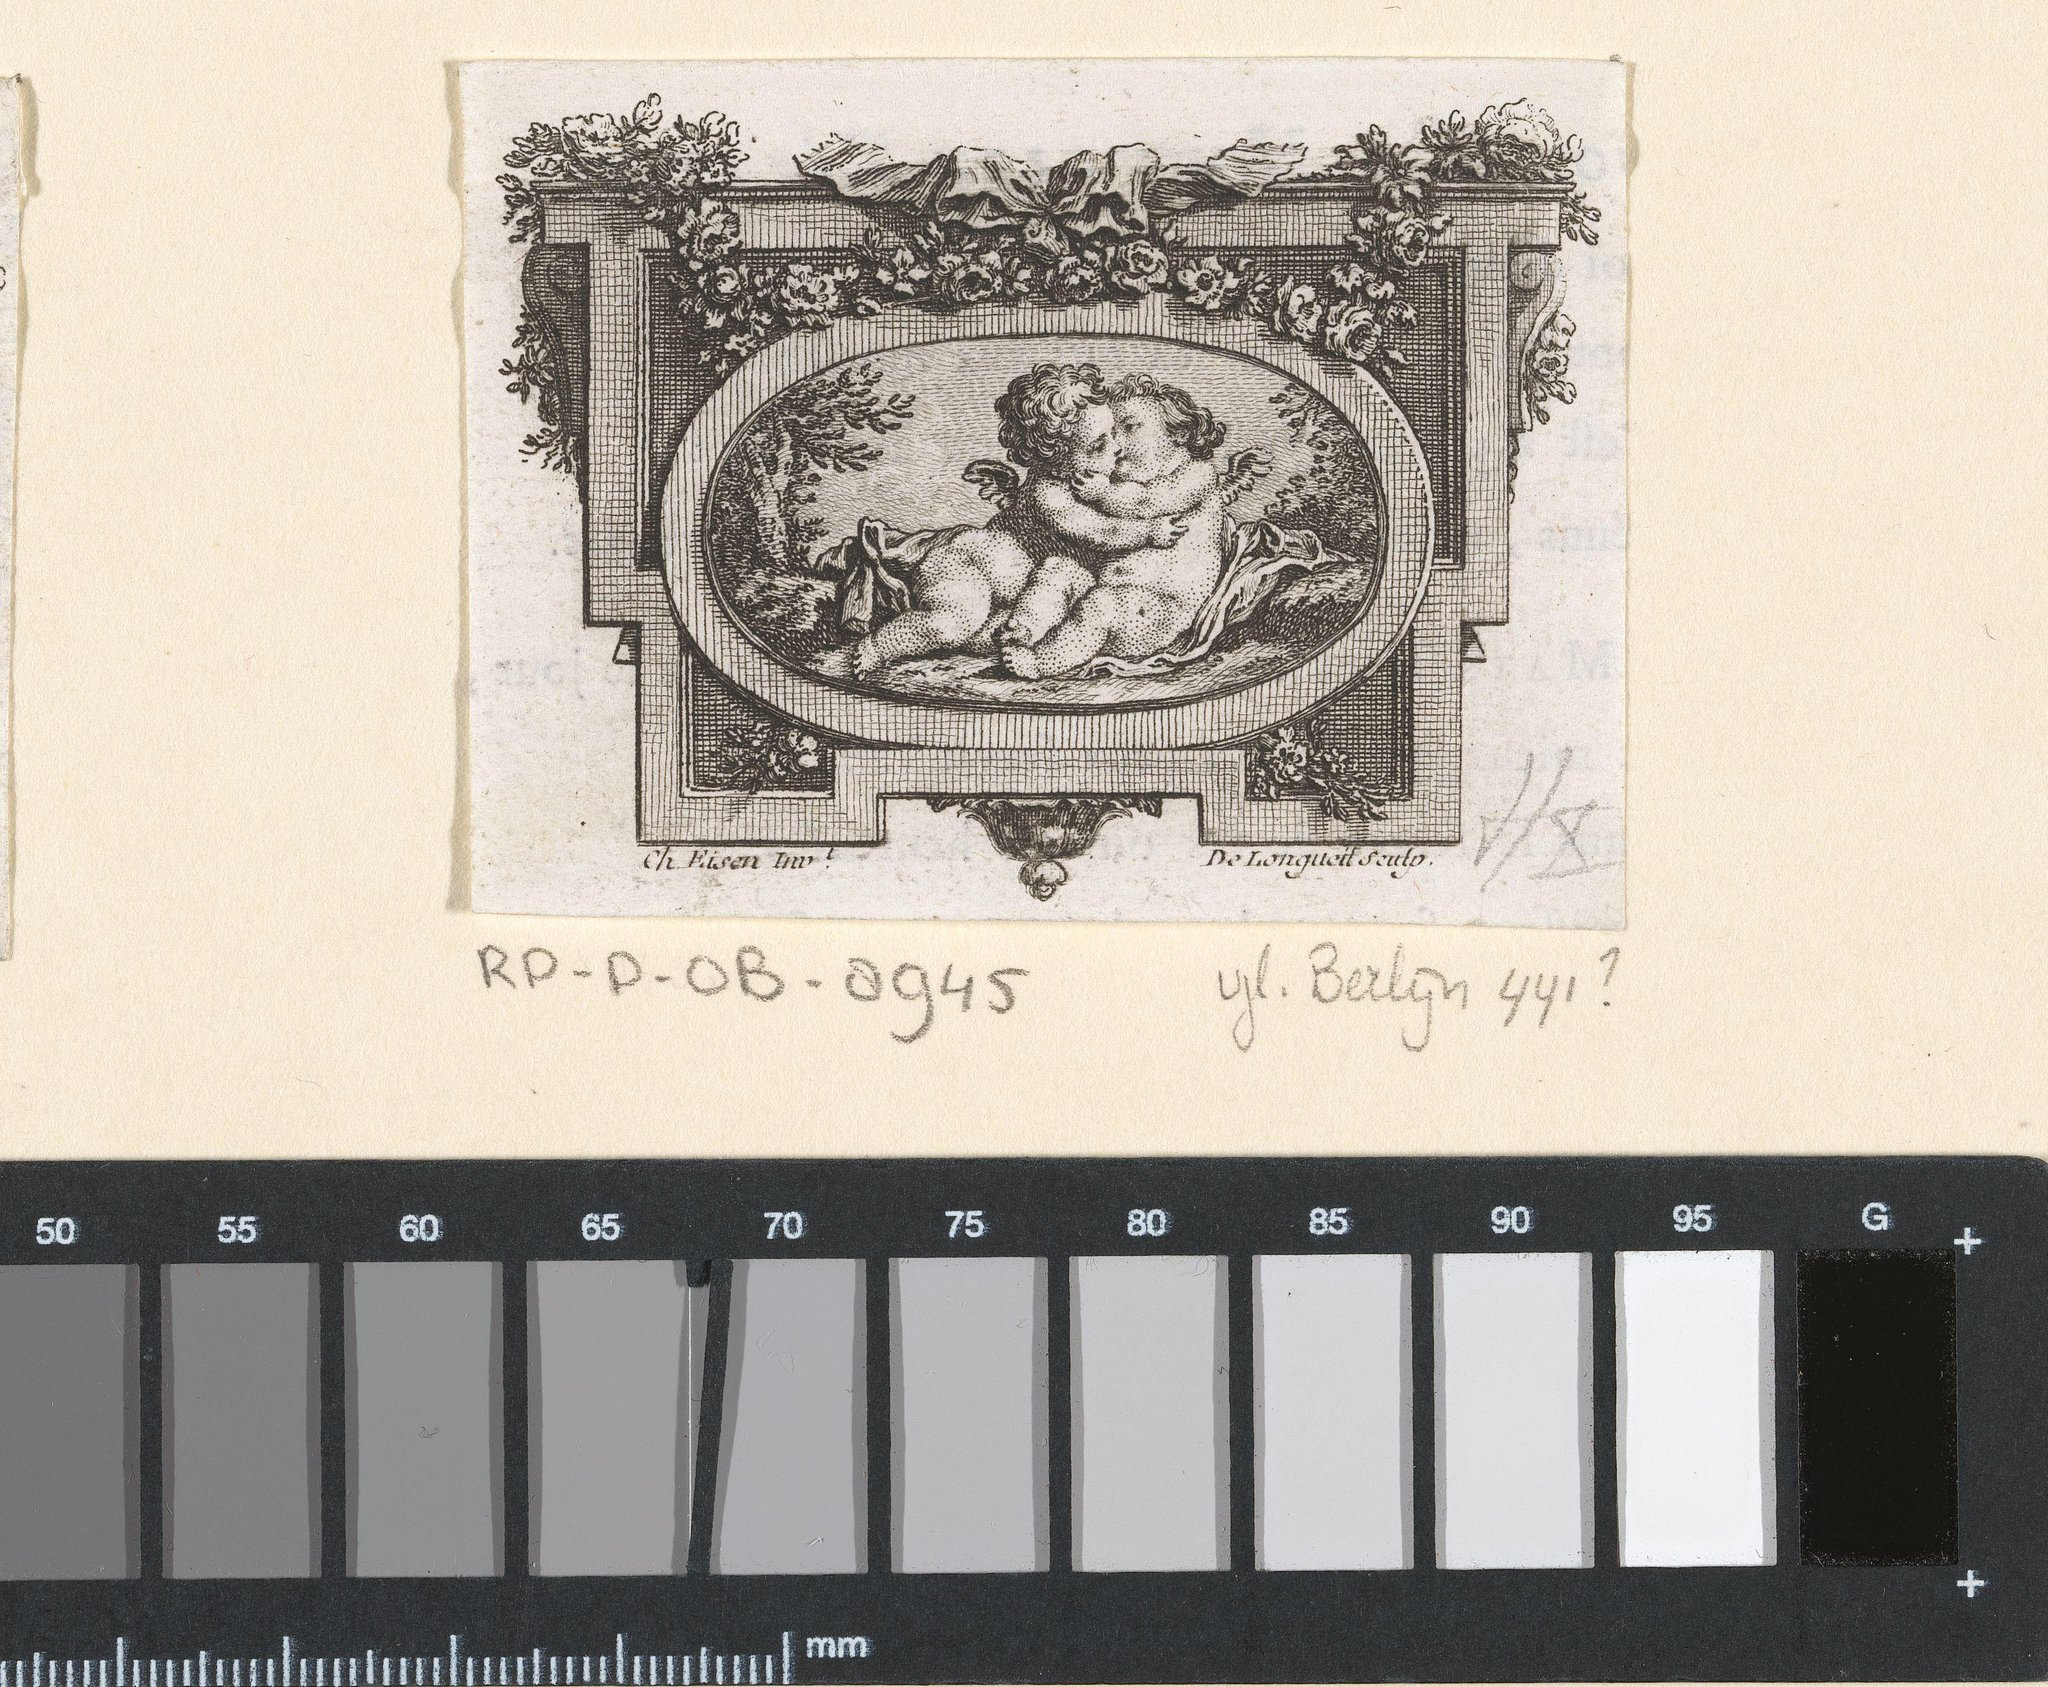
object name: ornament print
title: Vignet met twee putti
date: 1763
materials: paper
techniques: etching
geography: france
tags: (lovers) kissing each other, vignette, cupids: 'amores', 'amoretti', 'putti'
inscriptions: collector's mark: Lugt 2228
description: Vignet met twee kussende putti in een rechthoekige omlijsting.